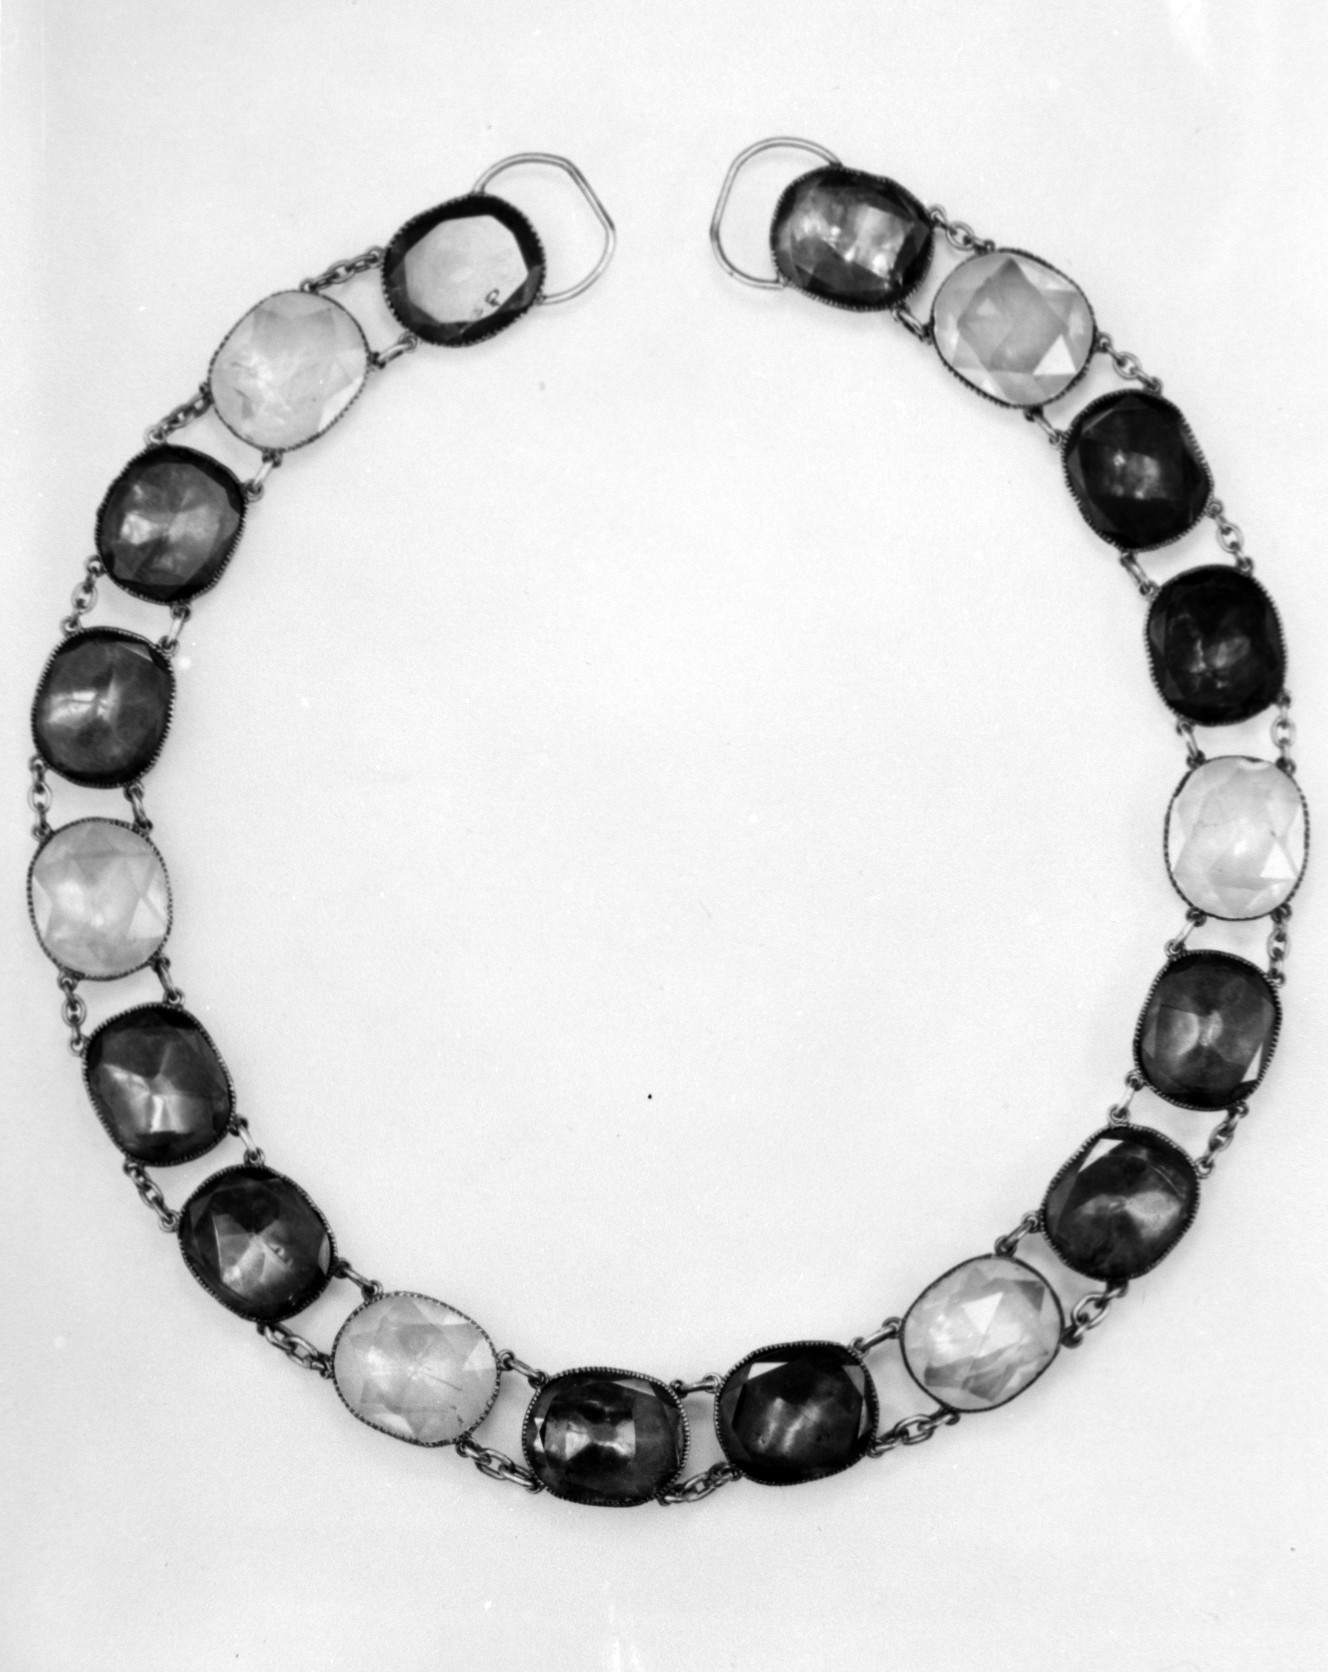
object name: necklace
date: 1701-1900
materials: gilt bronze, glass